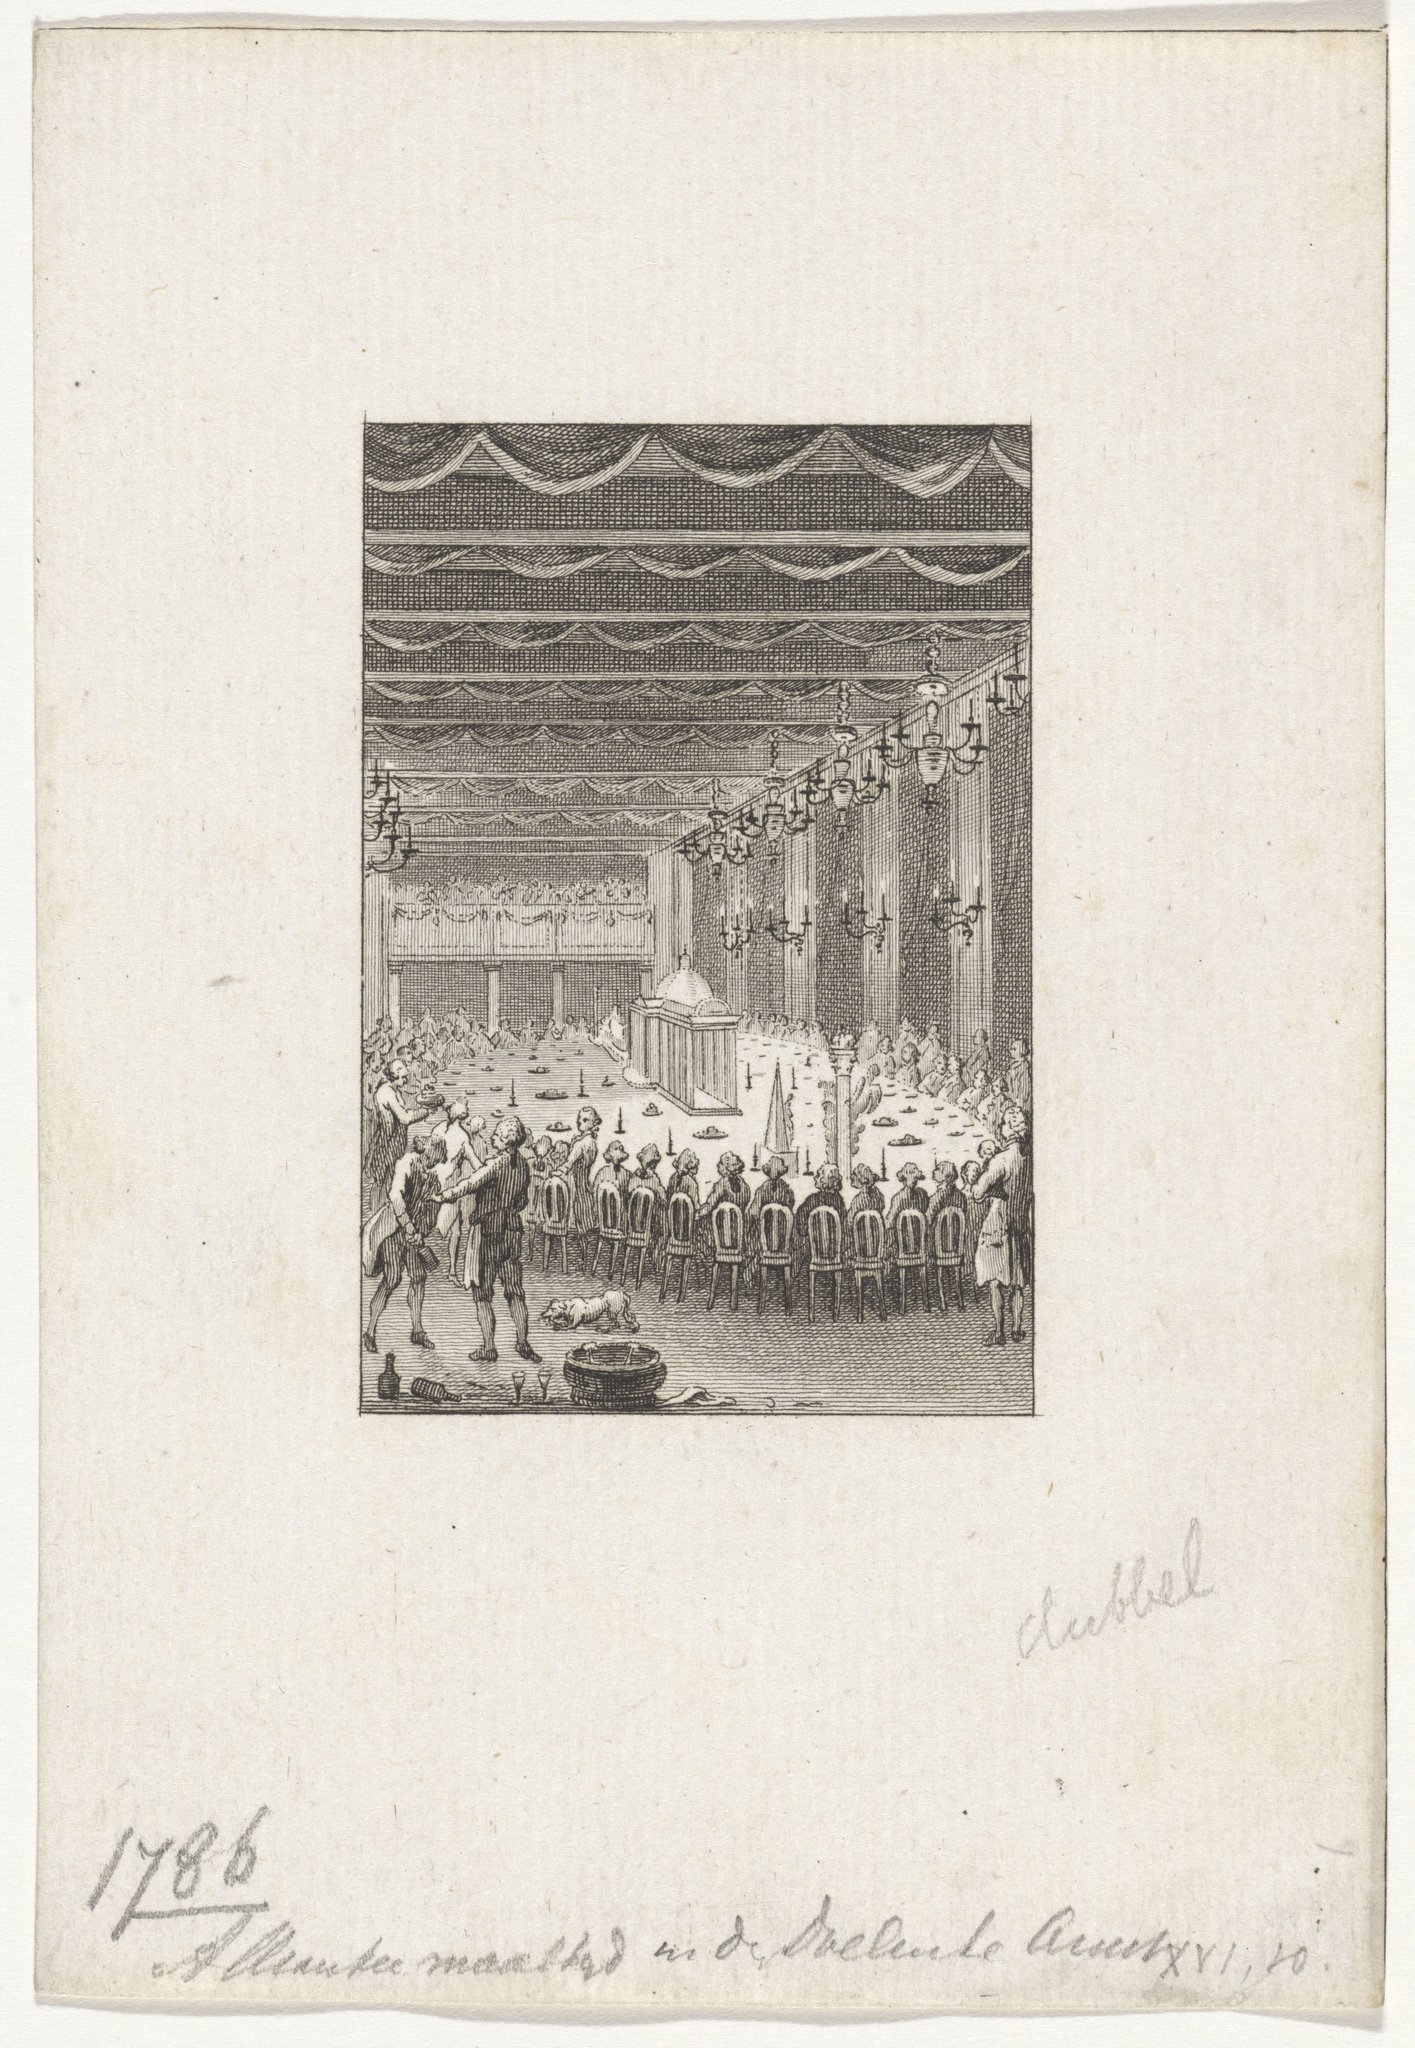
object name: history print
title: Alliantiemaaltijd te Amsterdam, 1786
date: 1783-1795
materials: paper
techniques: etching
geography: amsterdam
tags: festivities on events of national importance (+ eating and drinking ~ festive activities), celebration meal, feast, banquet, alliance with france (1785)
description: De feestelijke maaltijd gehouden op 27 januari 1786 in de Garnalen Doelen (Handboogdoelen) te Amsterdam om de Alliantie met Frankrijk (gesloten op 10 november 1785) te vieren. Groot gezelschap gezeten aan een tafel versierd met tafelstukken.